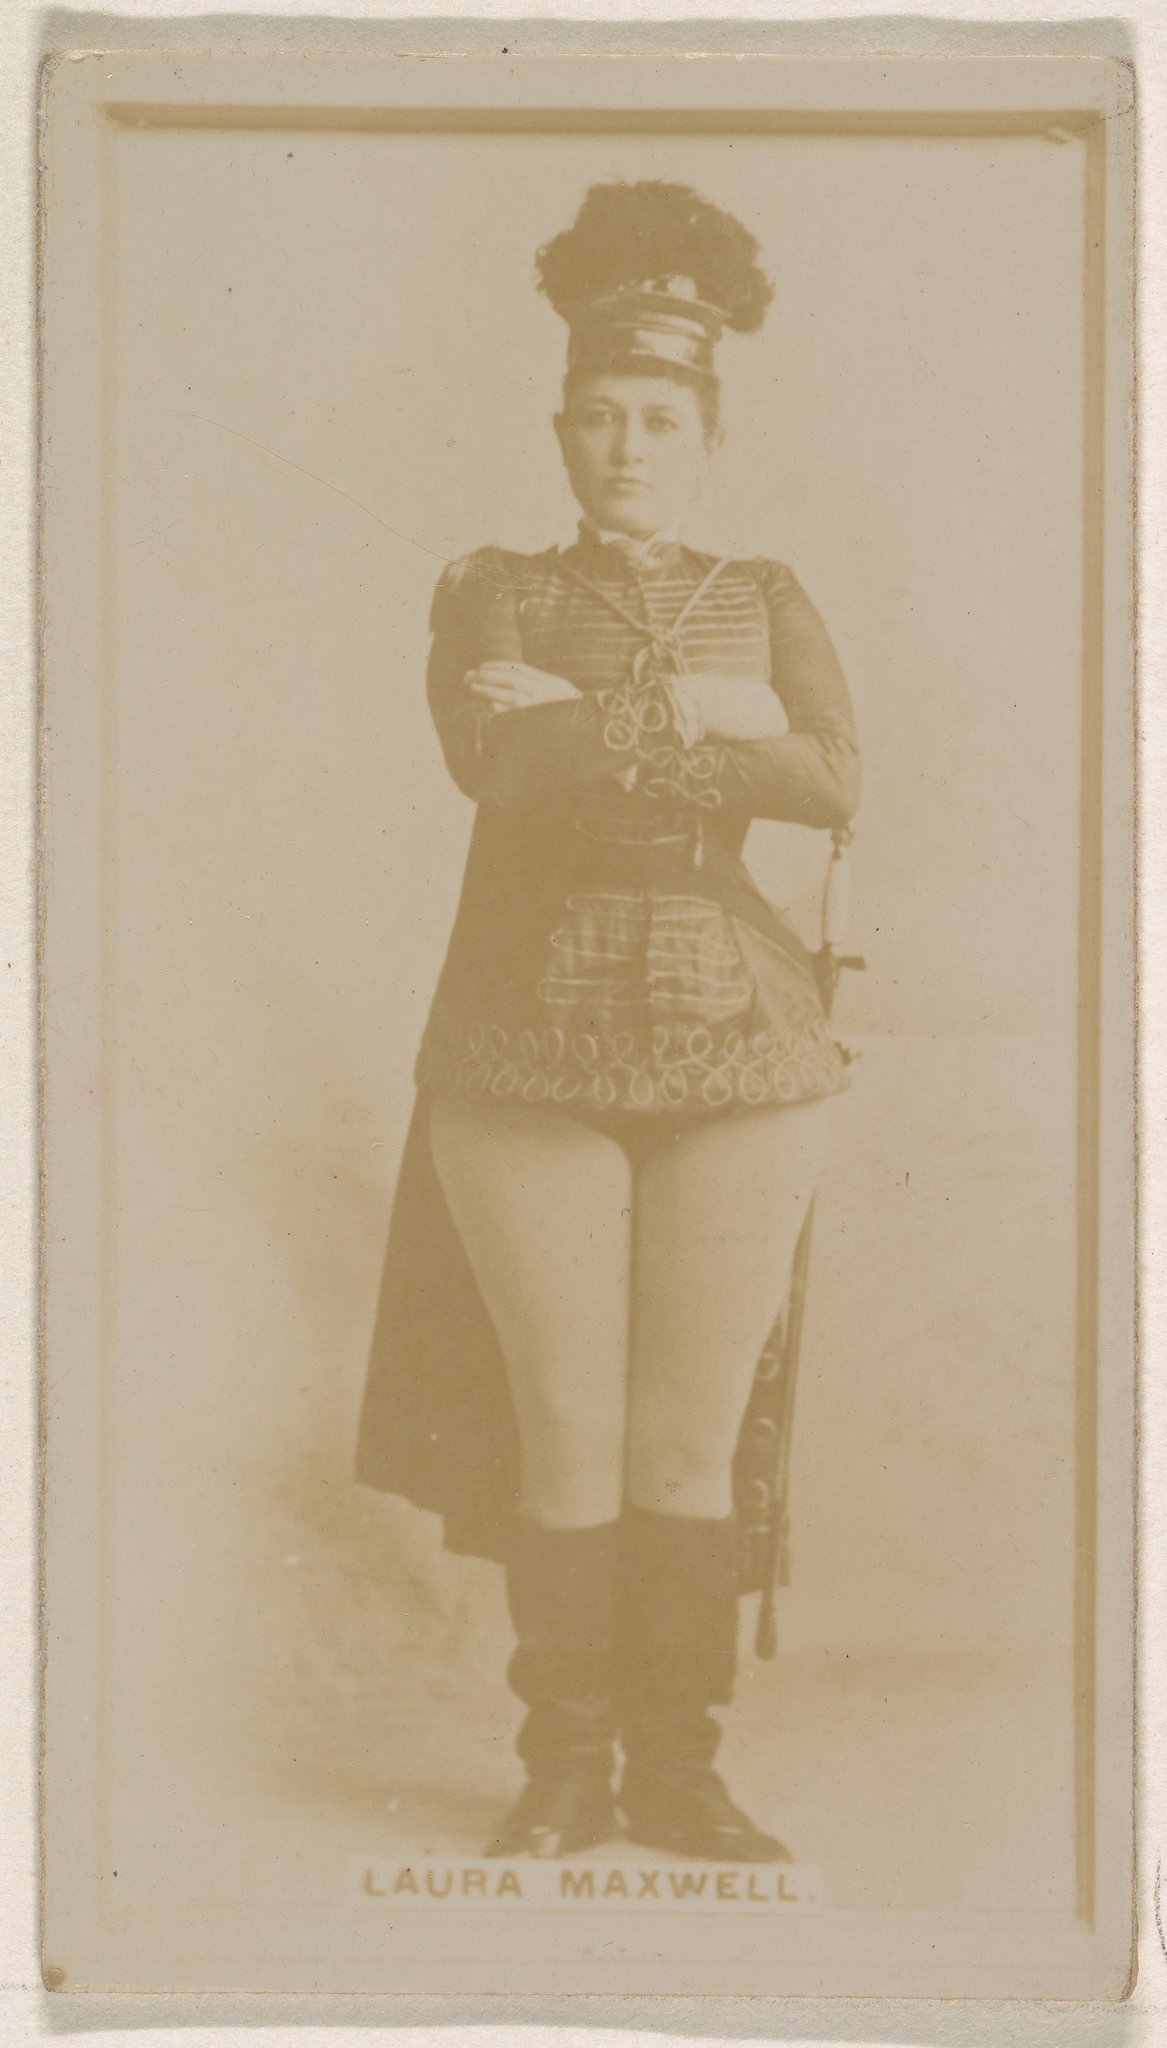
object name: photograph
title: Laura Maxwell, from the Actresses series (N245) issued by Kinney Brothers to promote Sweet Caporal Cigarettes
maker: kinney brothers tobacco company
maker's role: publisher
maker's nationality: american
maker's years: 1869-2011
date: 1890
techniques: albumen silver print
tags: portraits,women,actresses